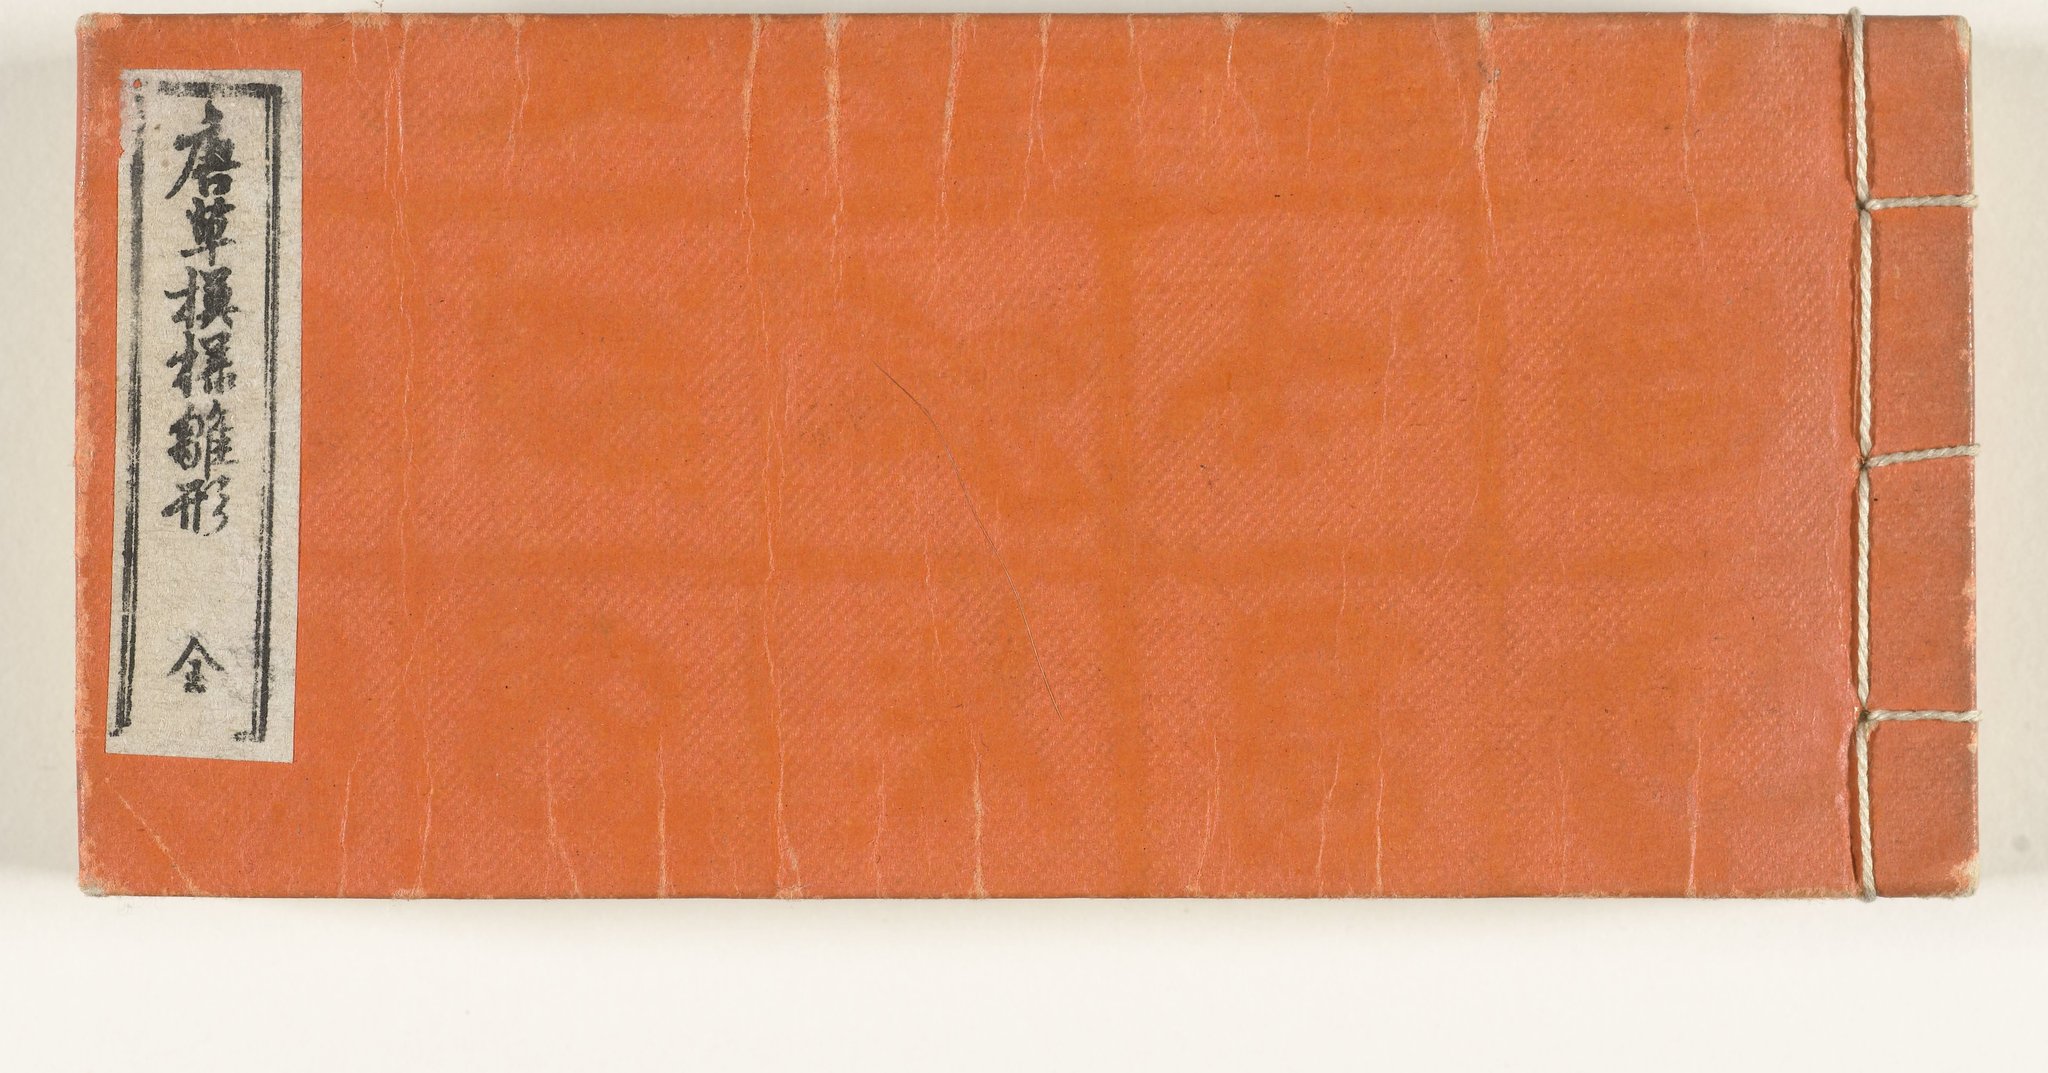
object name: book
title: Karakusa moyo hinagata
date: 1884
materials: paper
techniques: woodcut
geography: tokyo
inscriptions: name: ‘Joh. E. van Nierop’, collector's mark: Lugt 2166